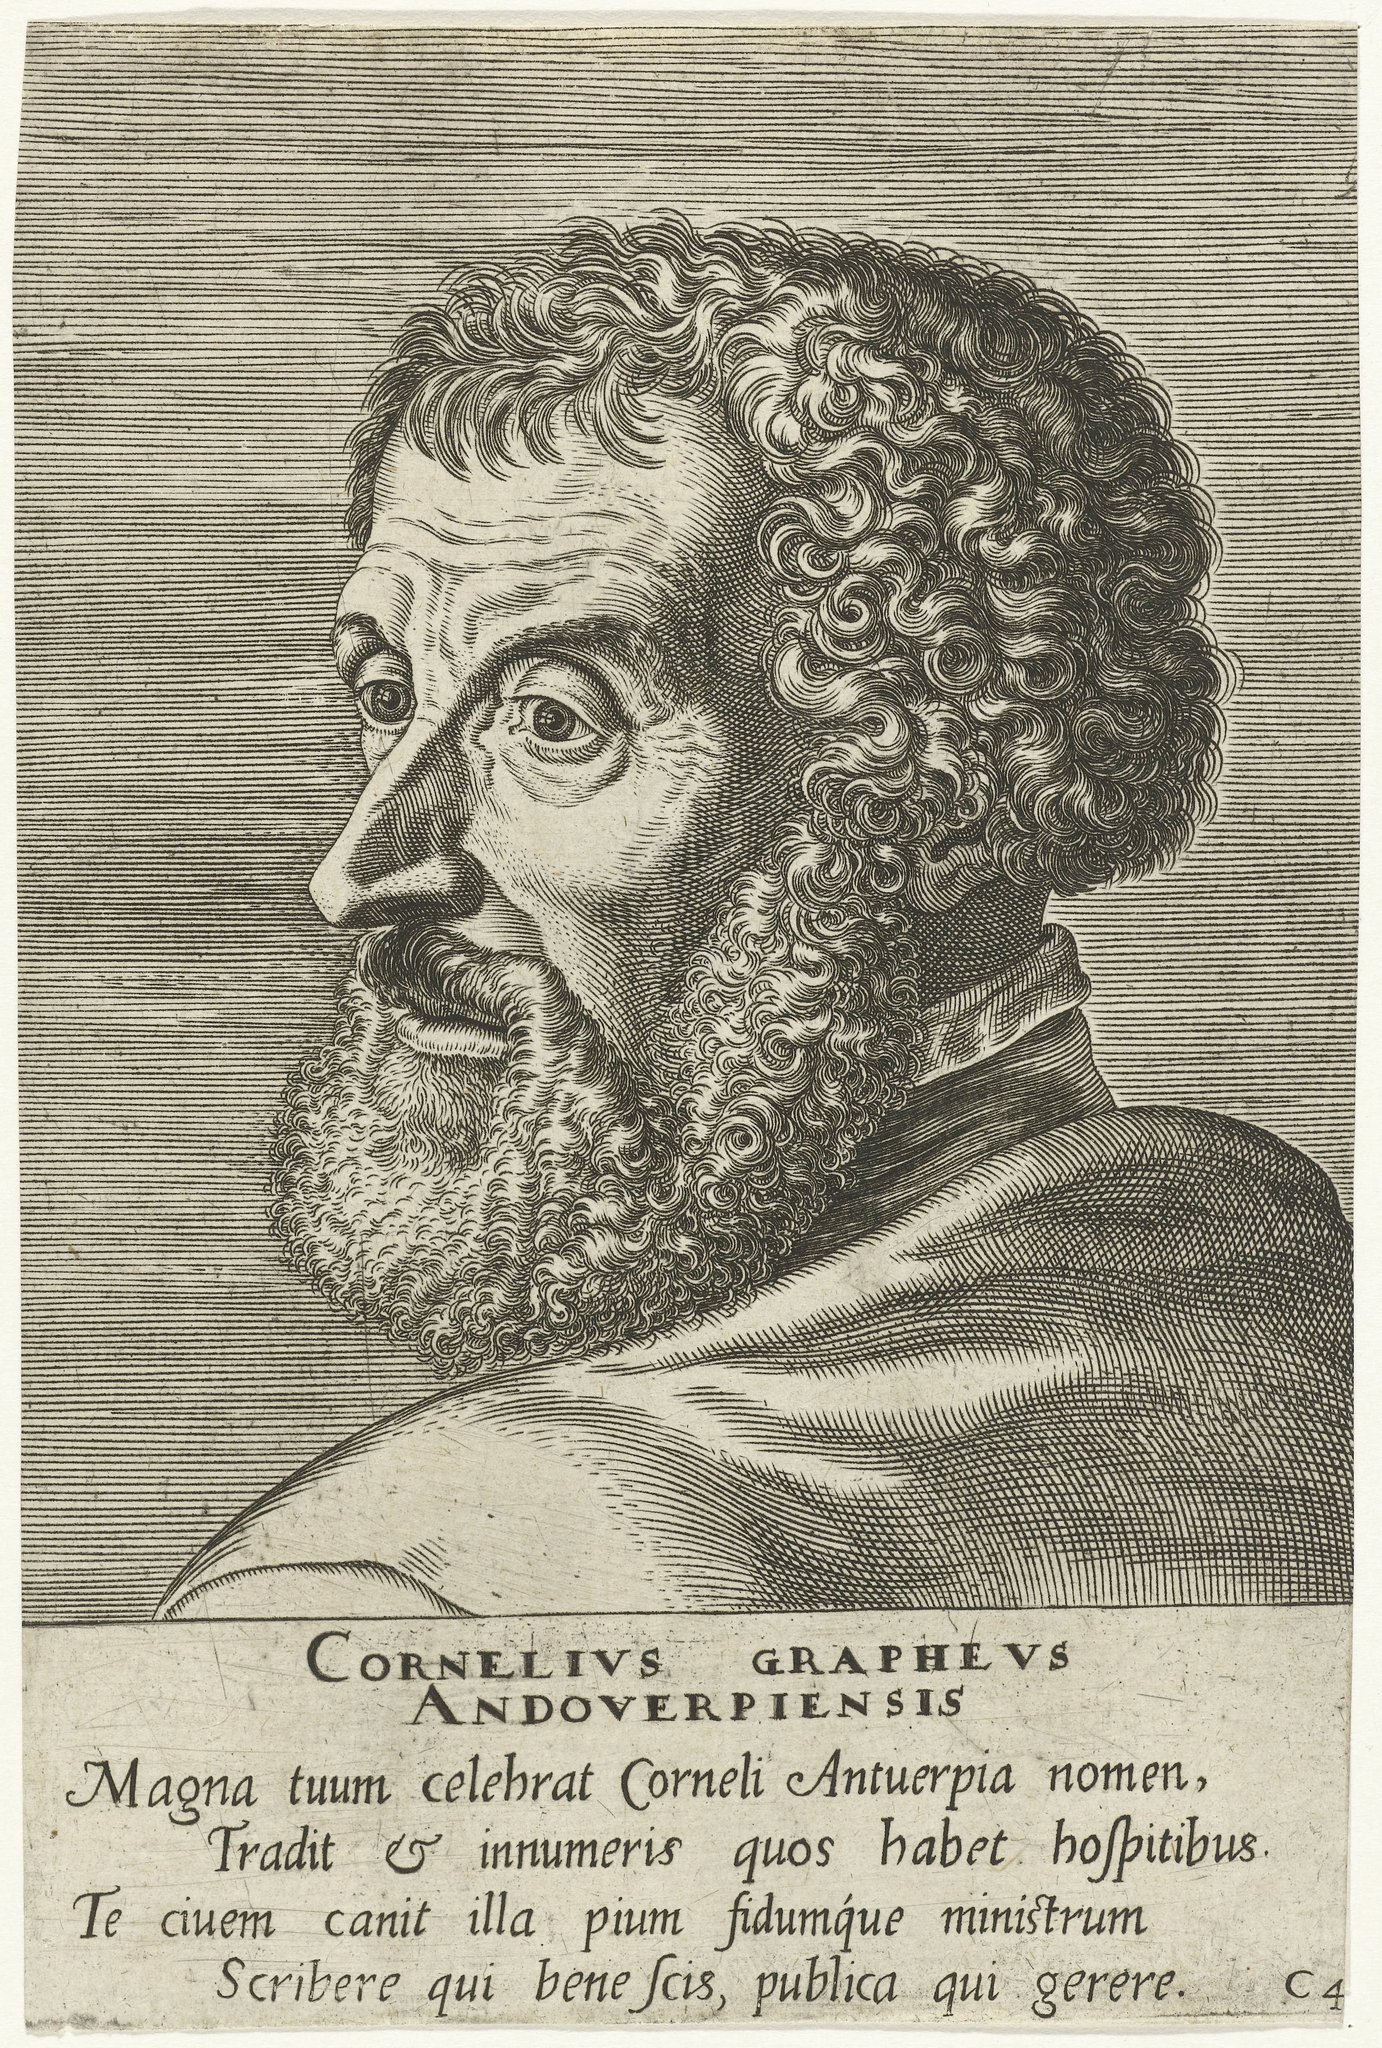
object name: print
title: Portretten van beroemde Europese geleerden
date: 1572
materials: paper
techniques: engraving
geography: antwerp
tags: aalst, secretaris, cornelis grapheus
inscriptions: collector's mark: Lugt 2228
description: Portret van Cornelis Grapheus, stadssecretaris van Antwerpen en humanist. Buste naar links. Genummerd C4. De prent heeft een Latijns onderschrift en maakt deel uit van een serie van beroemde Europese geleerden.